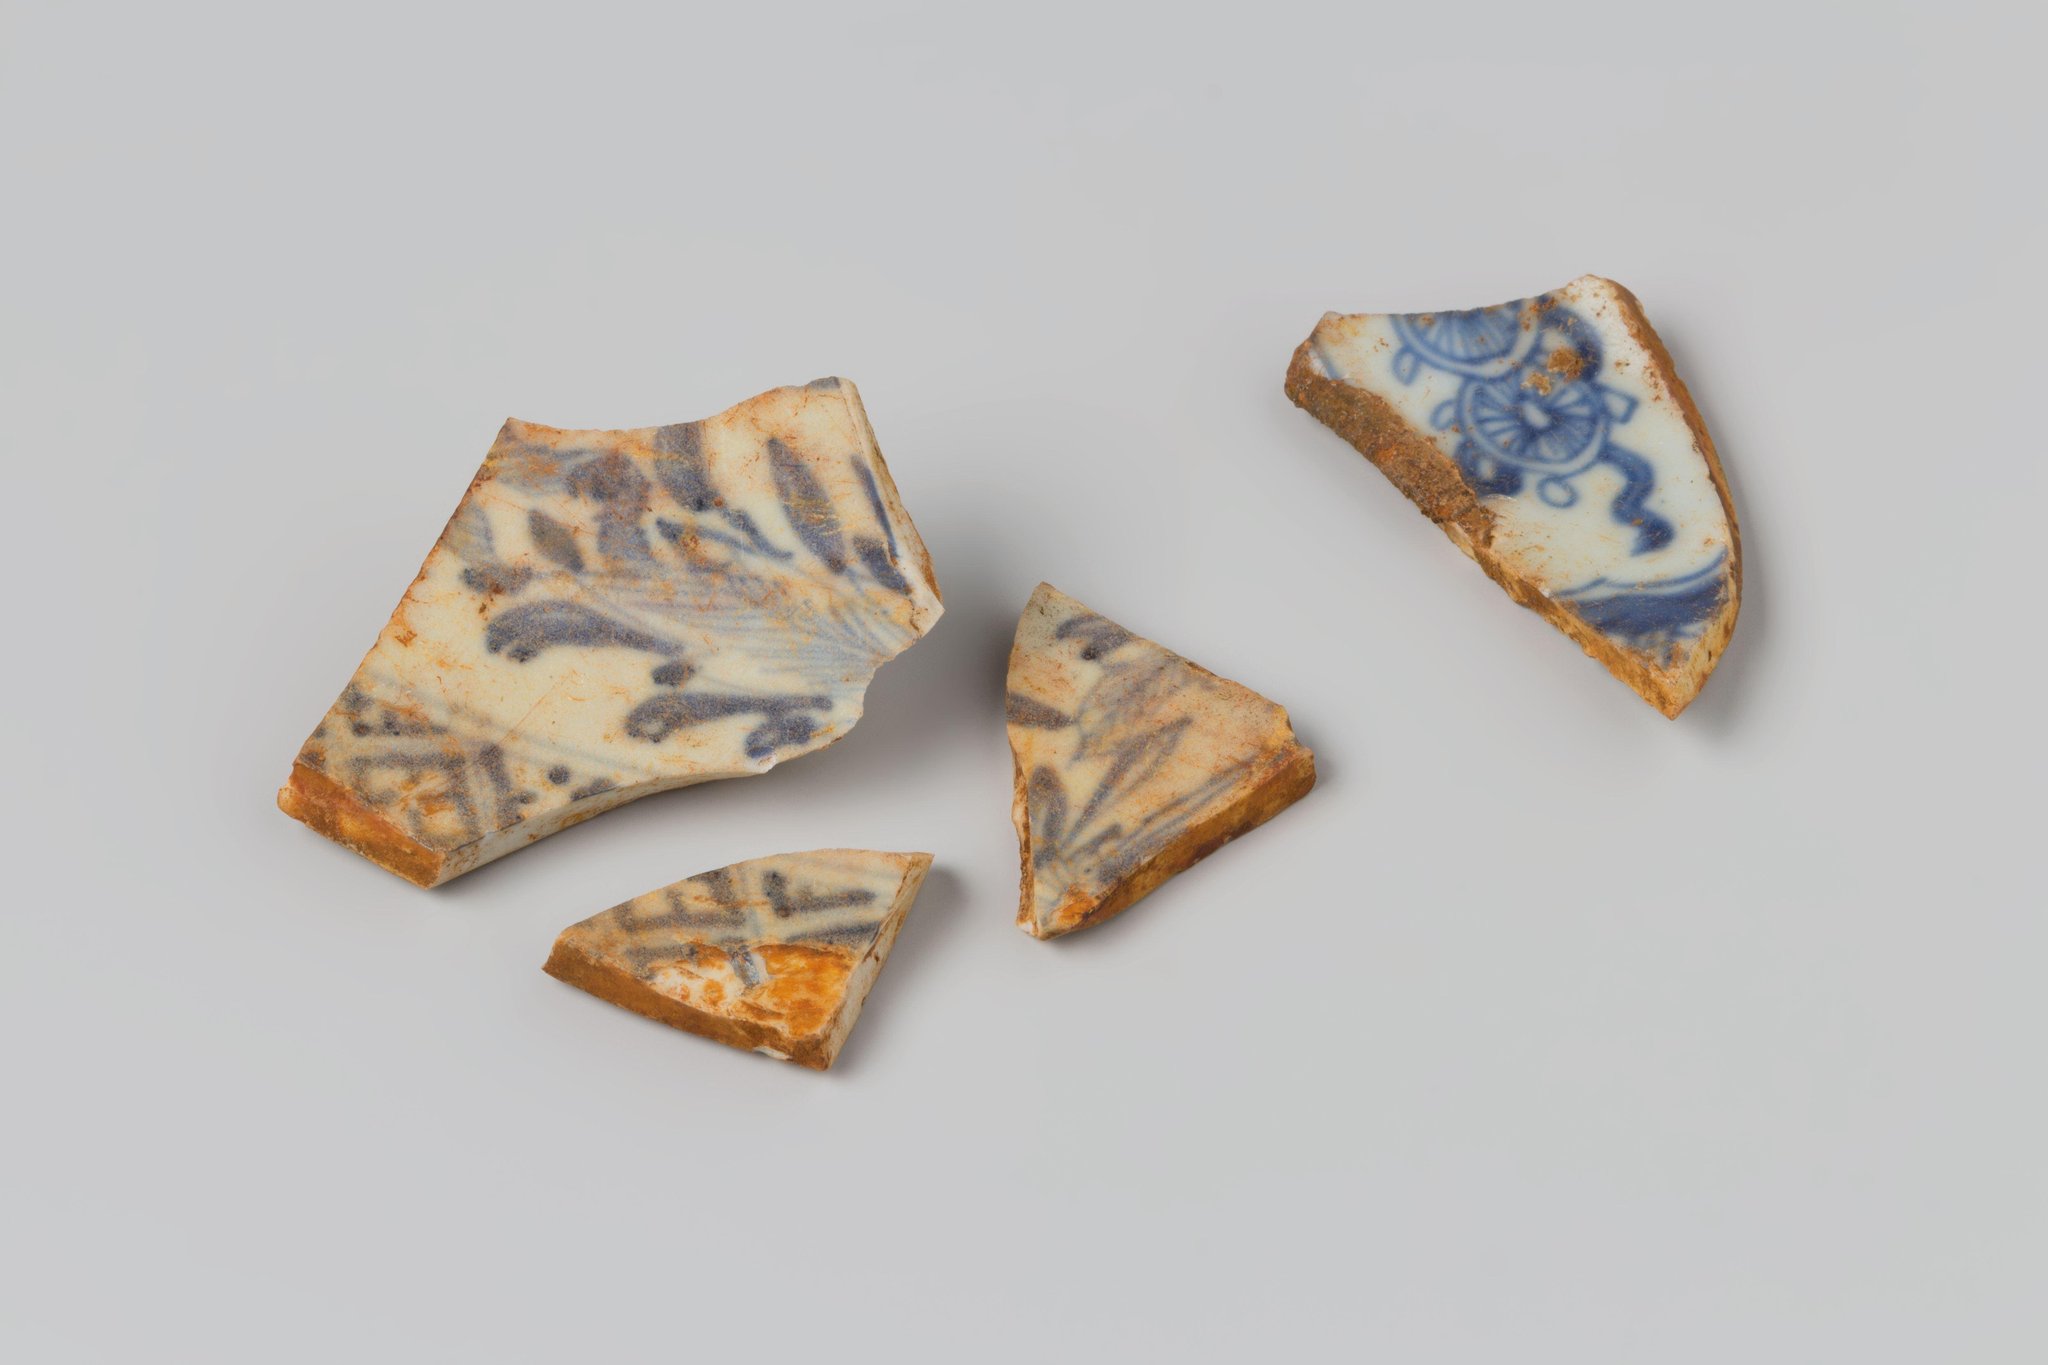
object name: sherd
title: Scherven van borden uit het wrak van de Oost-Indiëvaarder Hollandia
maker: Anonymous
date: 1700-1743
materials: porcelain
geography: netherlands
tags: verenigde oostindische compagnie, hollandia (schip), annet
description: Porcelain, plate, type 2; fragm of base sim. NG 1980-27H507.